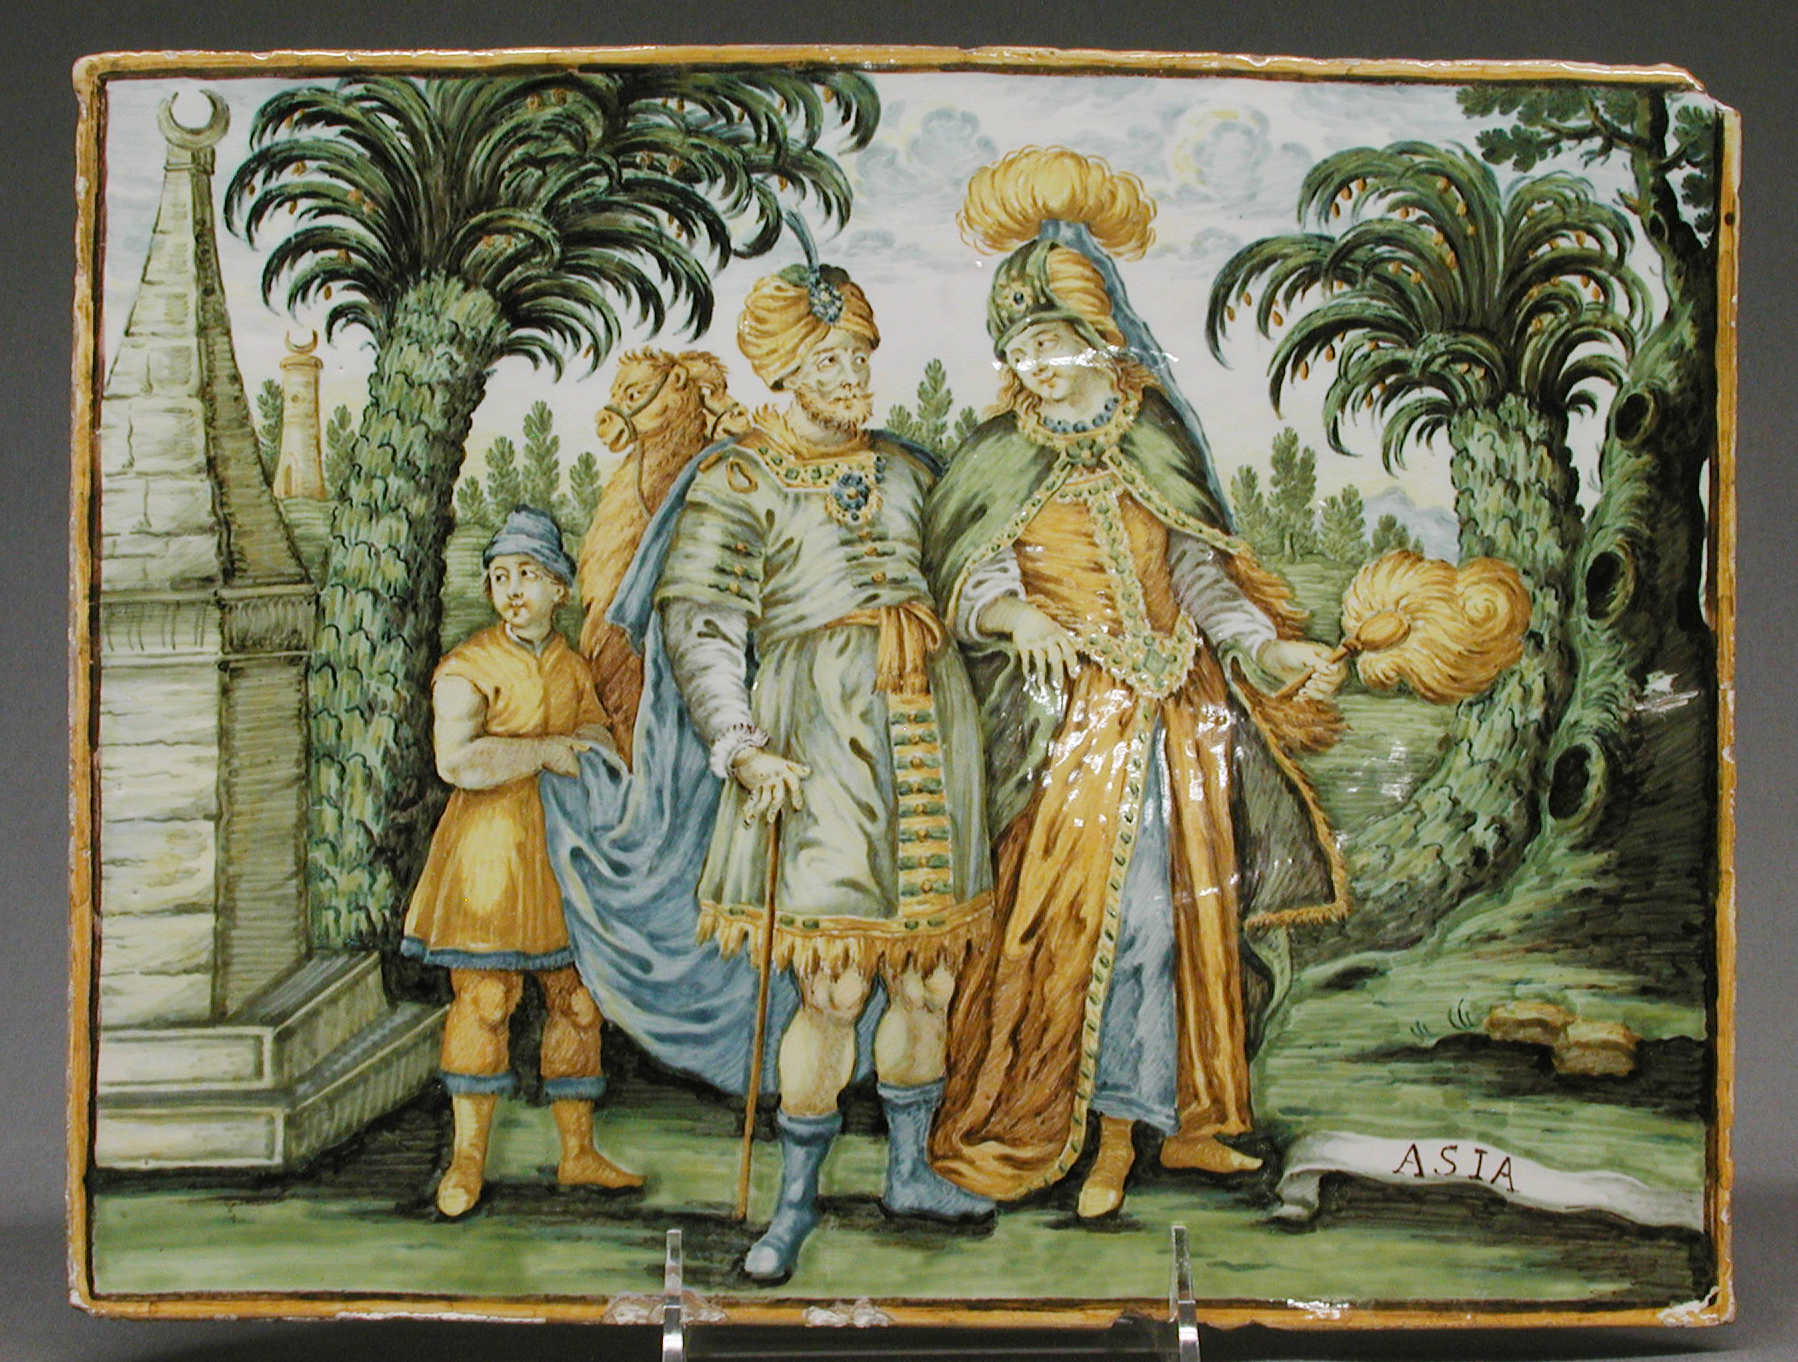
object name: tile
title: Asia (part of a set)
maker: castelli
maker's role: maker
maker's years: 1700-1900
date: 1801-1900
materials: earthenware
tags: animals,men,women,trees